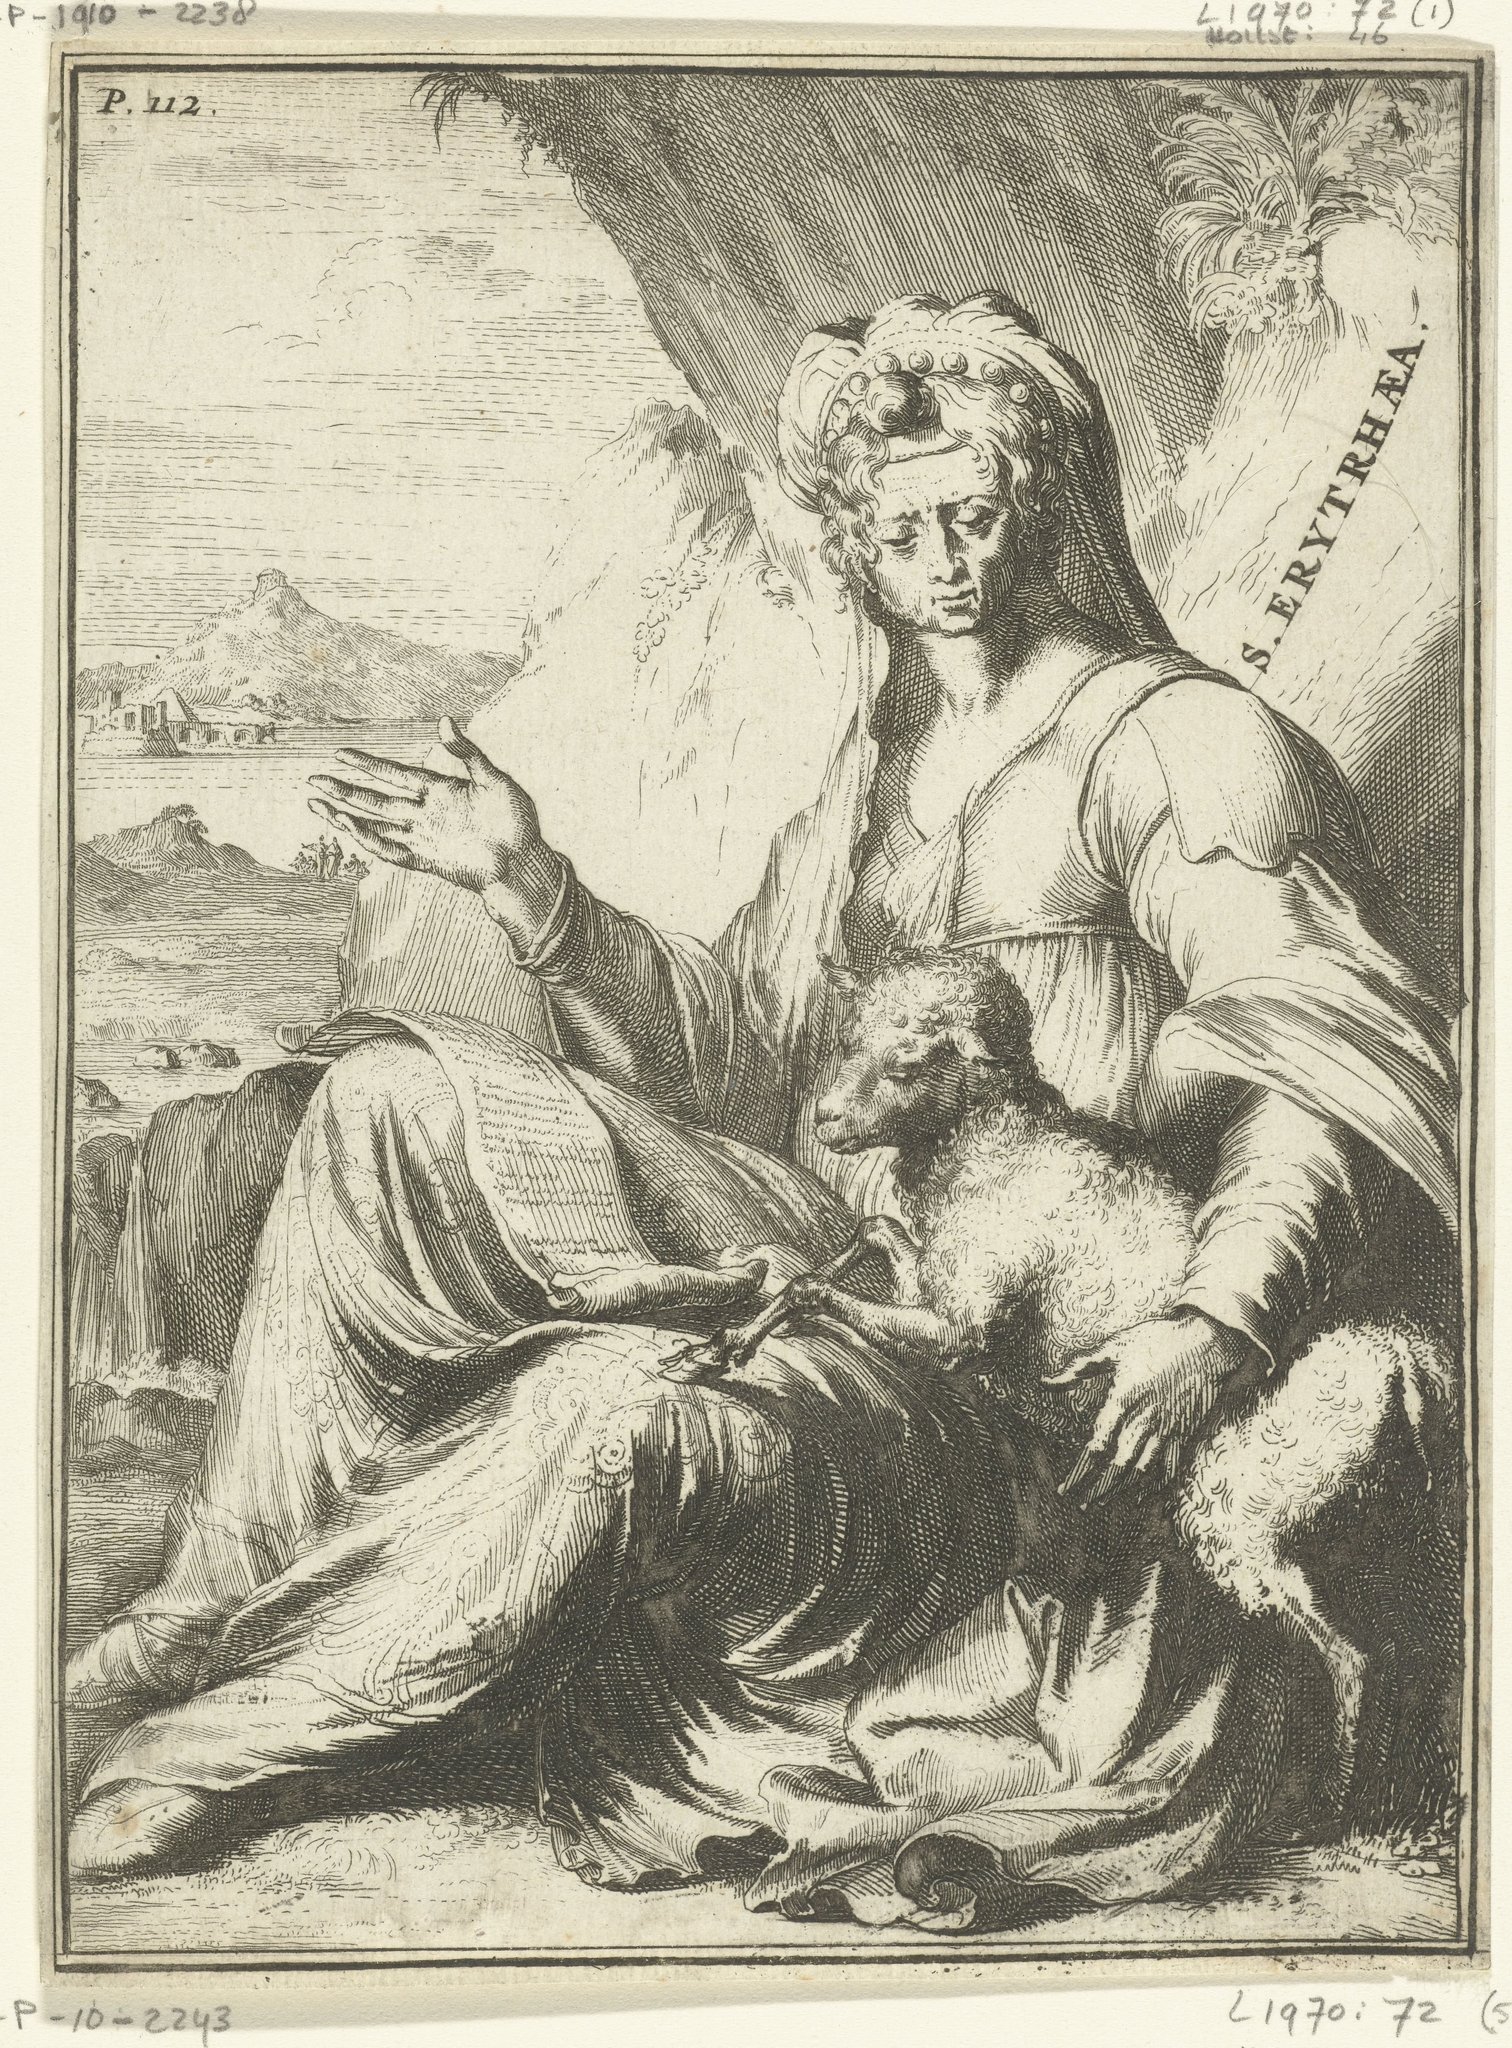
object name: book illustration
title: Twaalf sibillen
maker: romeyn de hooghe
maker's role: draughtsman, goldsmith, painter, print maker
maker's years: 1645-1708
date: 1688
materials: paper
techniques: engraving, etching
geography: netherlands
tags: erythraean sibyl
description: Illustratie voor: Servatius Gallaeus, Dissertationes de Sibyllis, earumque oraculis, Amsterdam, Dirk en Hendrik Boom, 1688, p. 112.